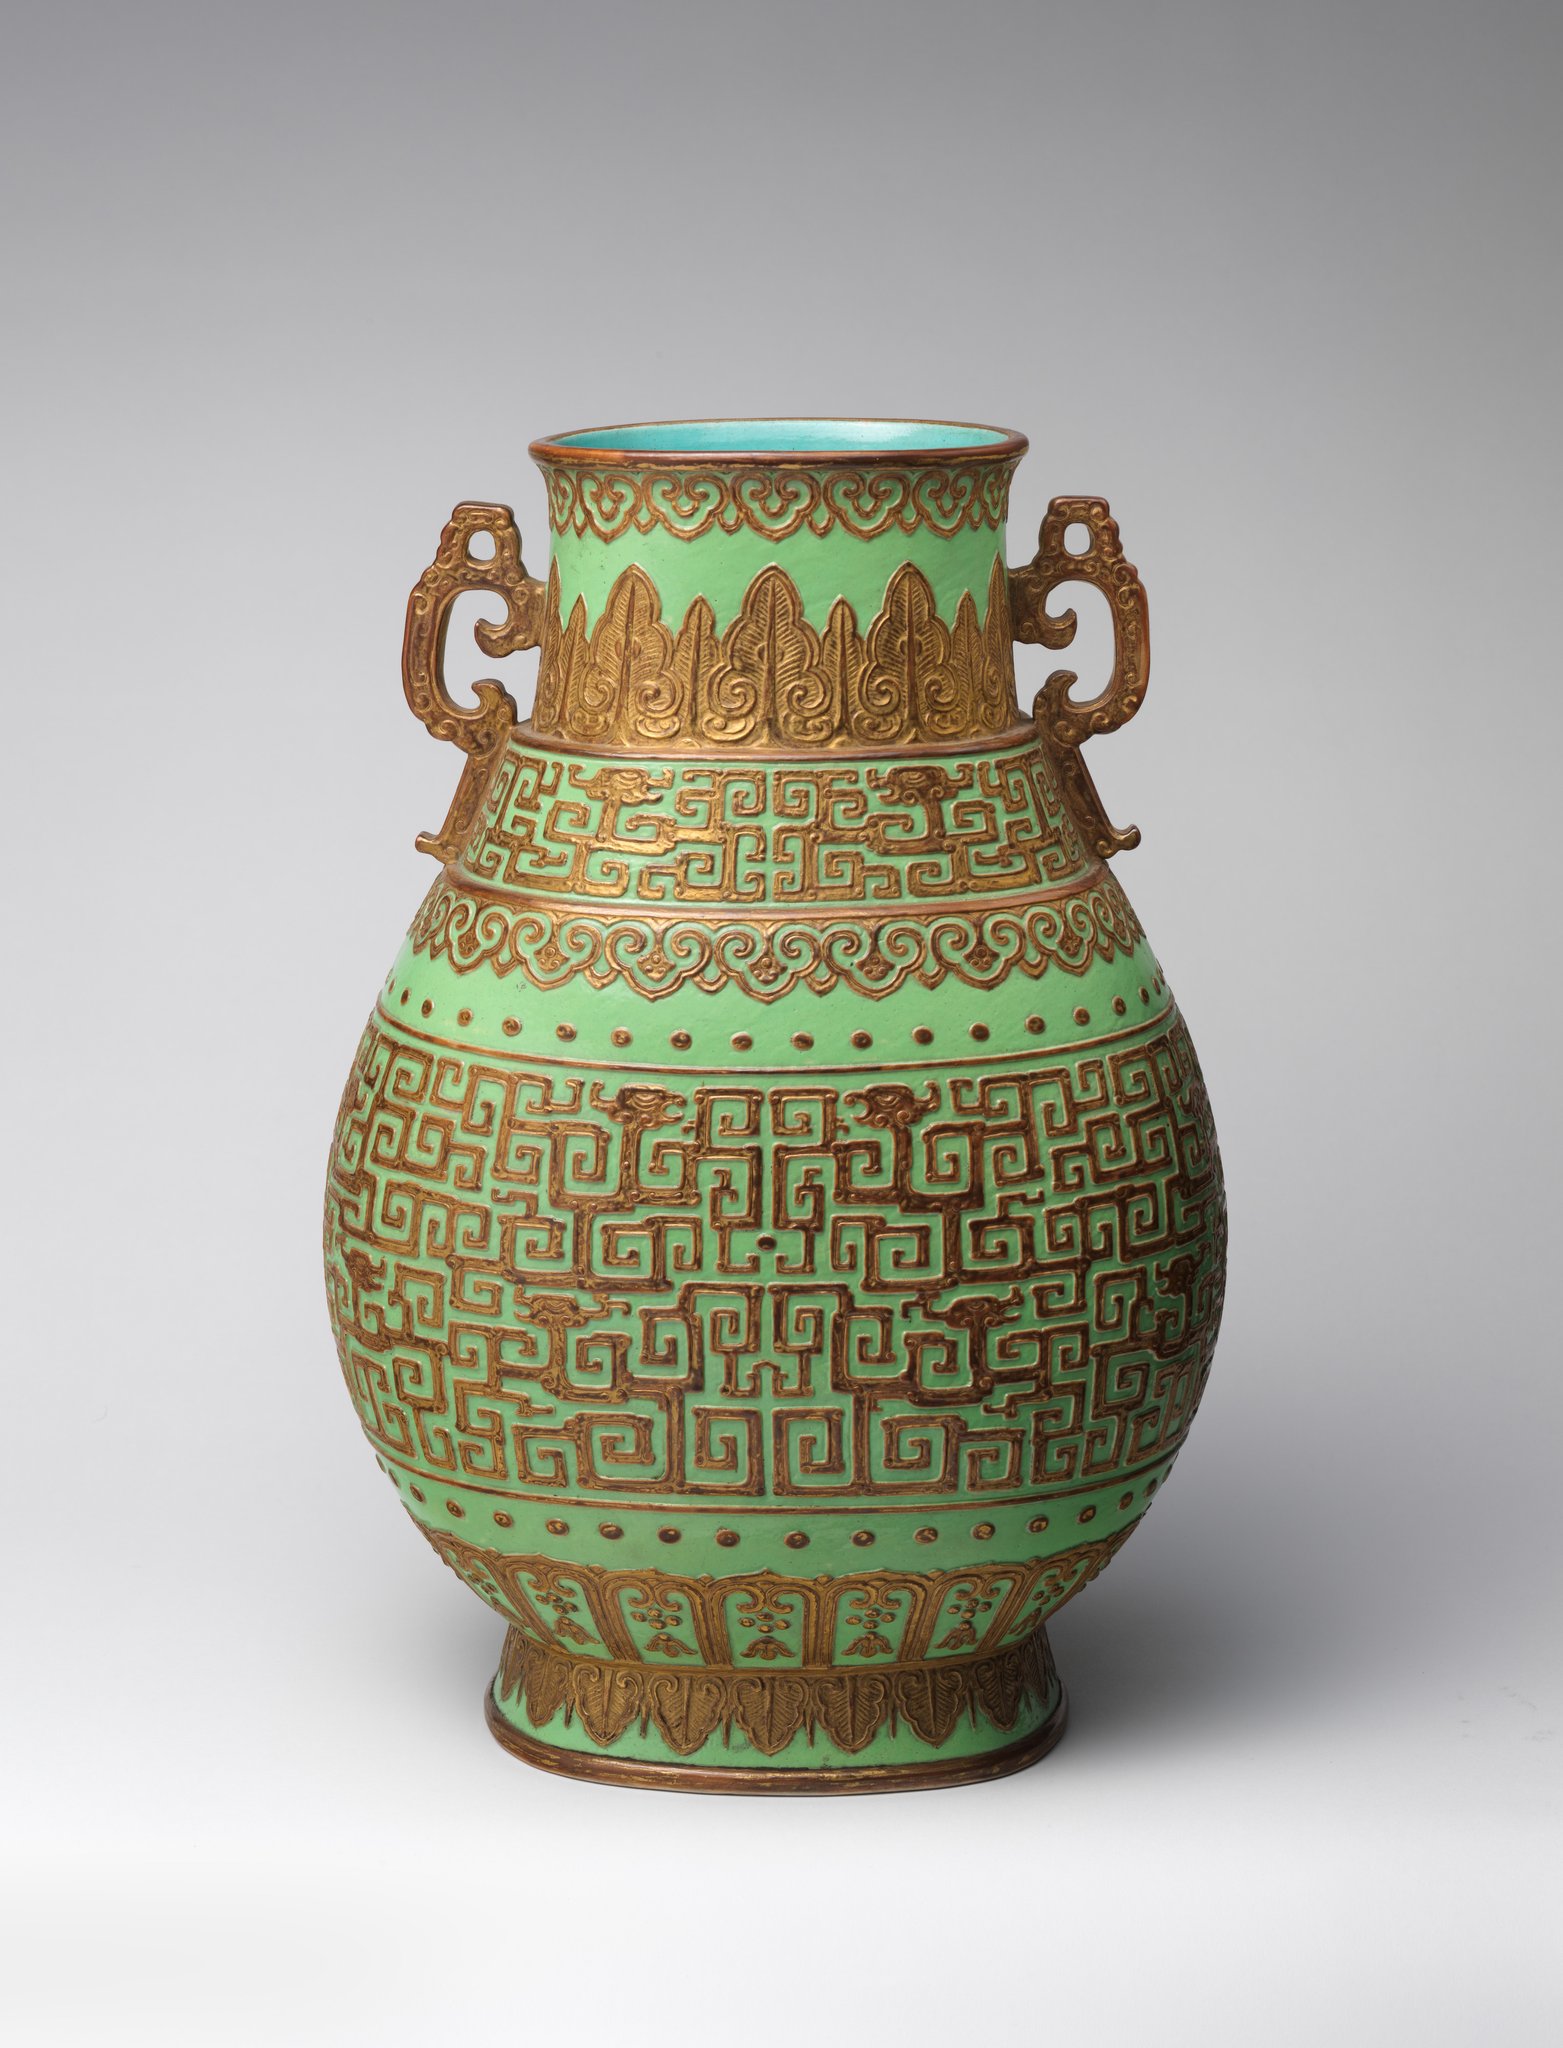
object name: vase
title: Vase with archaistic patterns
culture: chinese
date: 1734-1766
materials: enamel, porcelain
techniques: gilding, relief